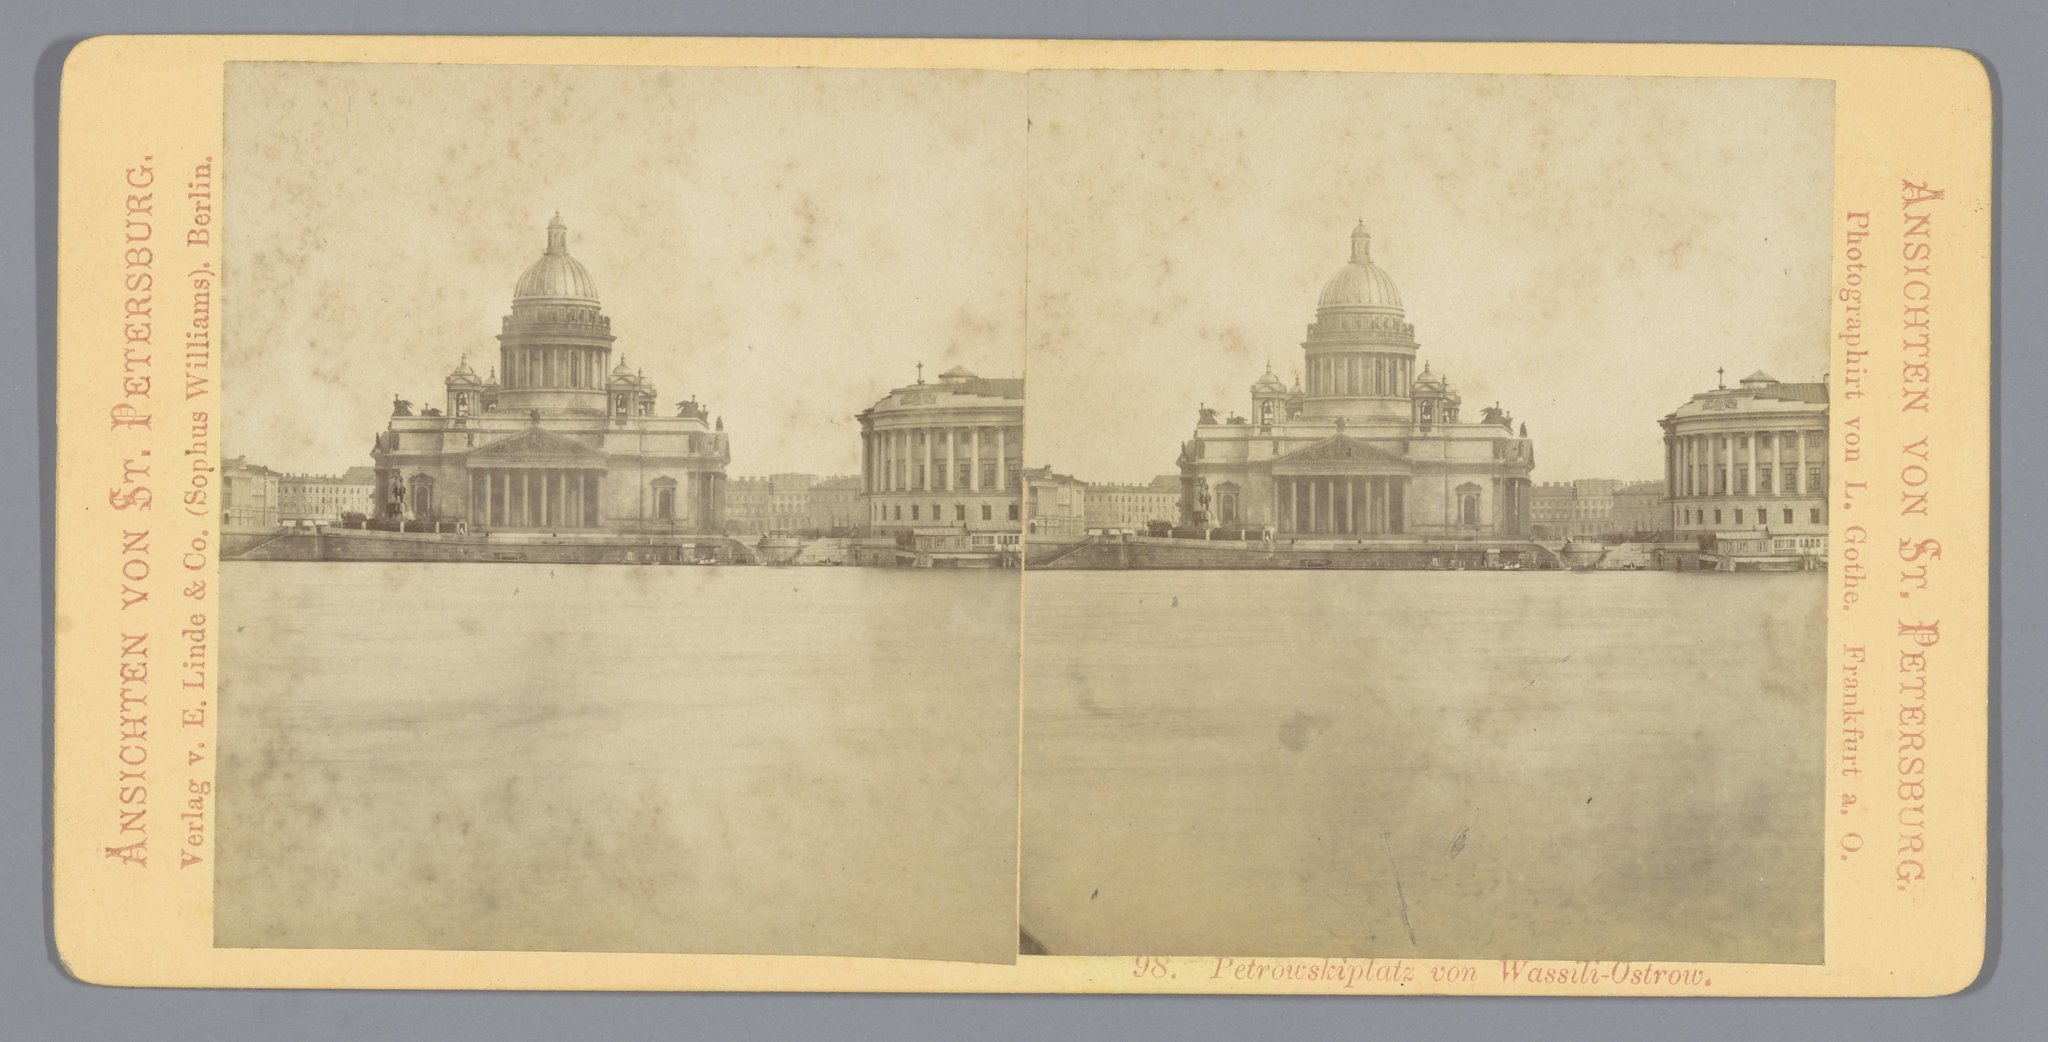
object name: stereograph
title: Petrowskiplatz von Wassili-Ostrow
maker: louis gothe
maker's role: fotograaf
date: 1850-1880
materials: cardboard, photographic support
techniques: albumen print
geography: berlin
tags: river, church (exterior)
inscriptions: number: ‘98.’, inscription: ‘Ansichten von St. Petersburg.’